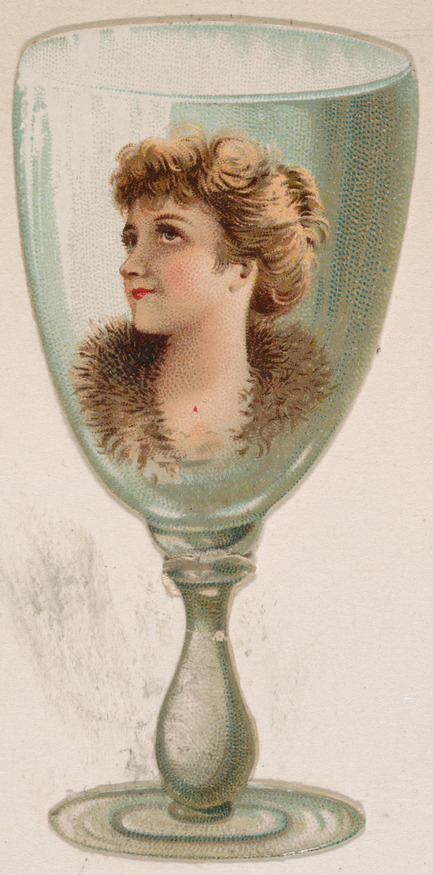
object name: print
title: Goblet, from the Novelties series (N228, Type 4) issued by Kinney Bros.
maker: kinney brothers tobacco company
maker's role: publisher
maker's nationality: american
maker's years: 1869-2011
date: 1889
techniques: color lithograph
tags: women,drinking glasses